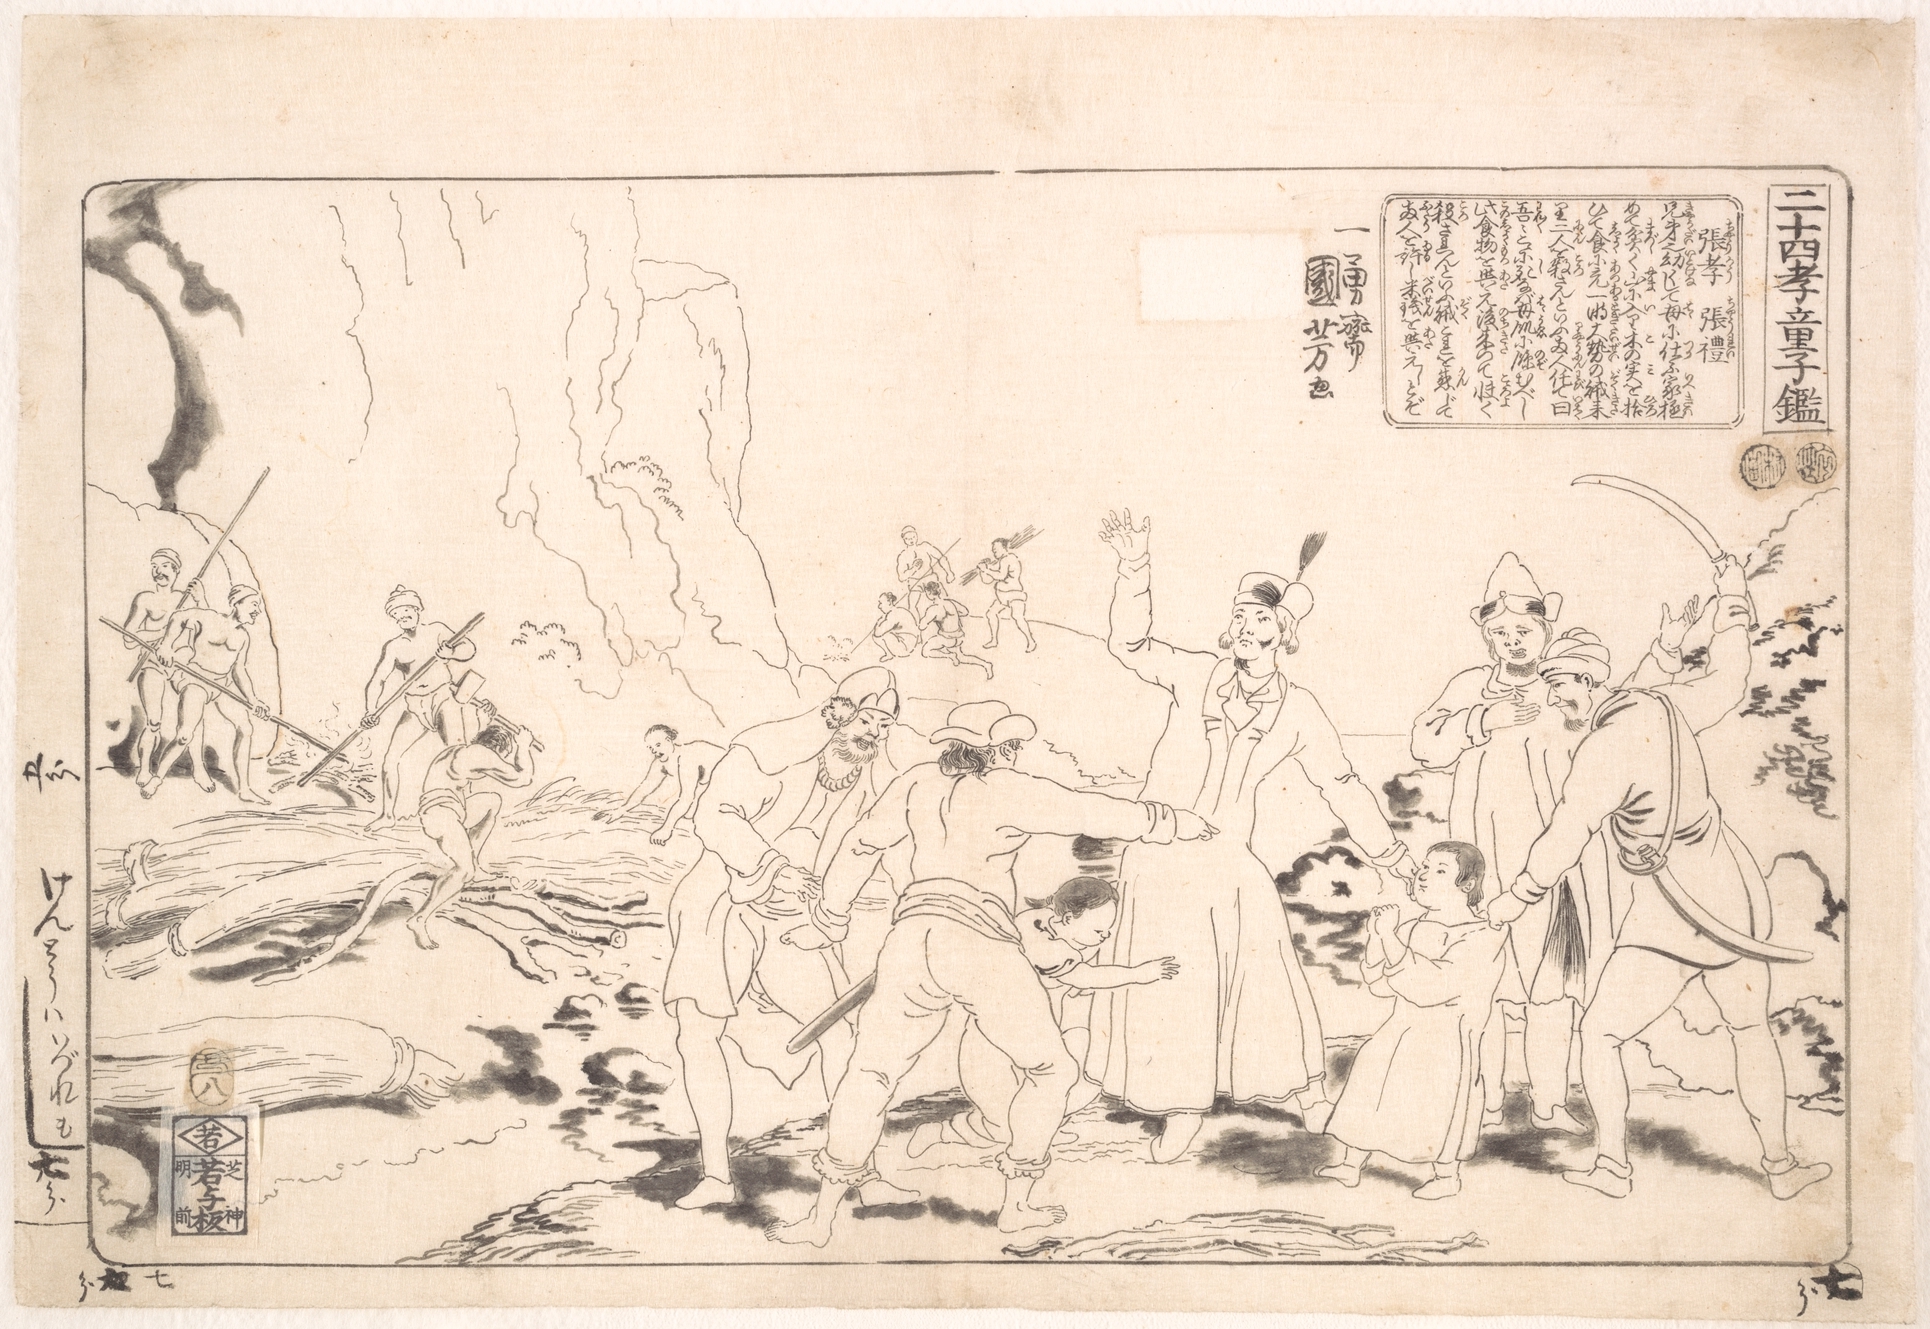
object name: print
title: Two Brothers Zhang Xiao and Zhang Li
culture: japanese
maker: utagawa kuniyoshi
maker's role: artist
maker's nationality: japanese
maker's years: 1797-1861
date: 1834-1866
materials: ink, paper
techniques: woodblock print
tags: swords,girls,men